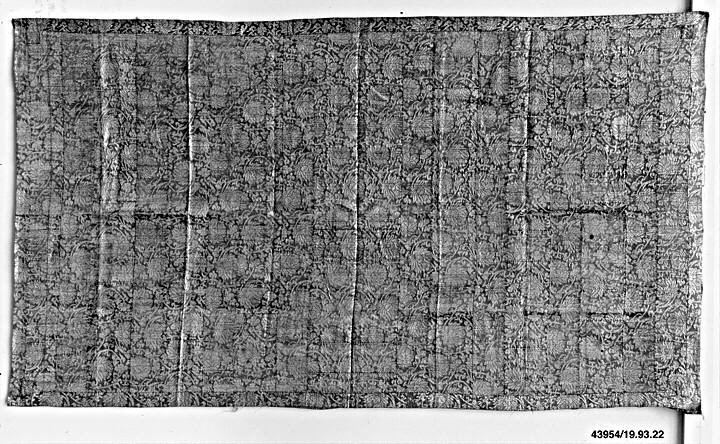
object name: robe, priest's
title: Nine-Panel Buddhist Monk’s Vestment (Kujō kesa) with Lotus Arabesque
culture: japanese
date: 1667-1766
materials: gold, silk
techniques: patterning